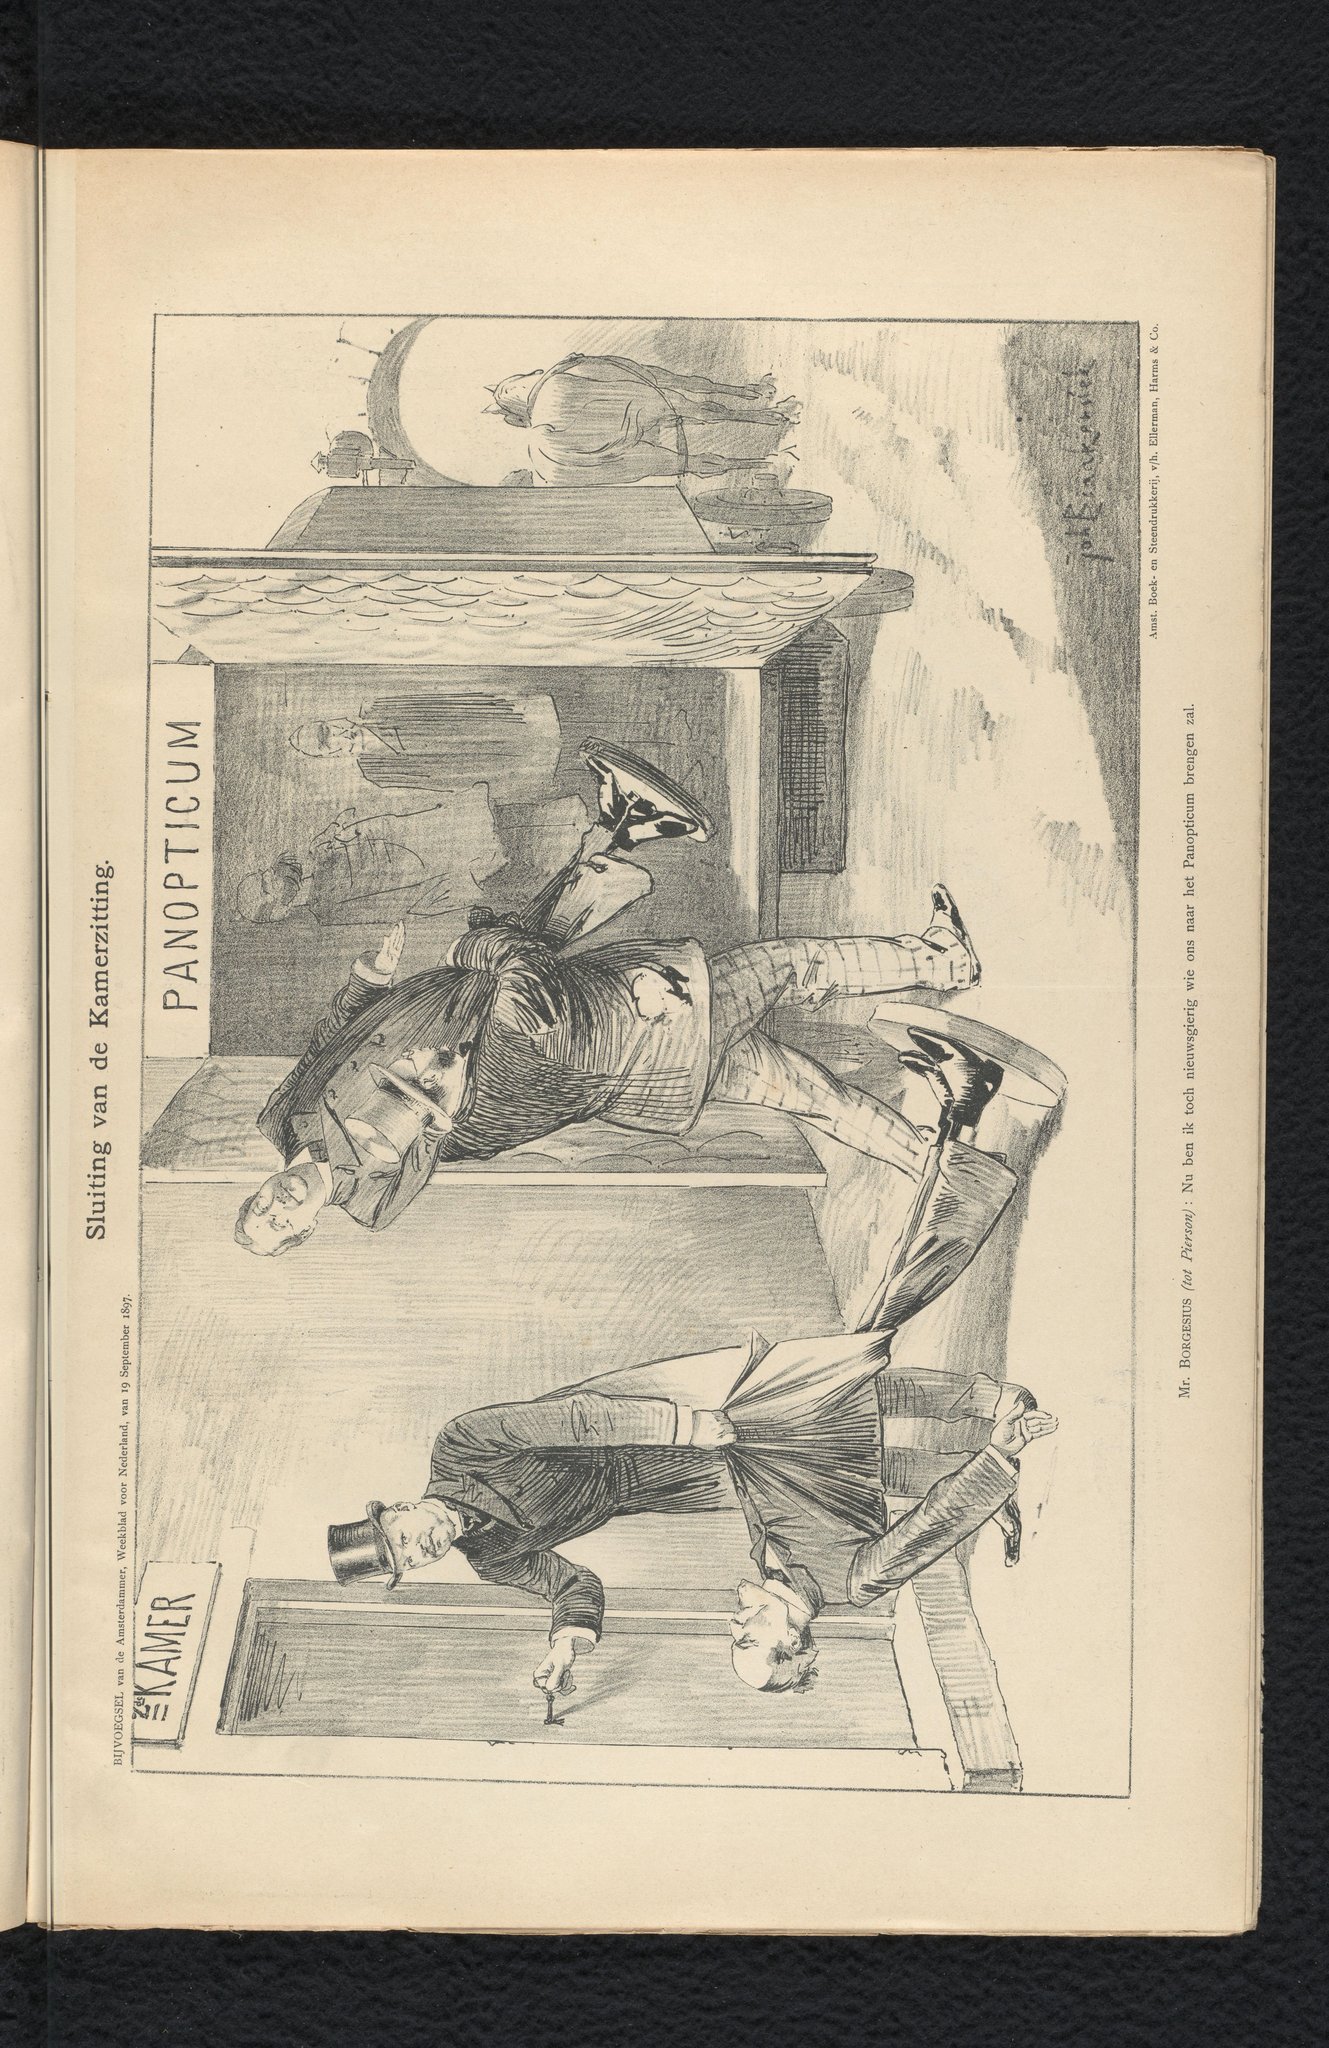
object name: cartoon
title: Sluiting van de Kamerzitting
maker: johan braakensiek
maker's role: draughtsman, print maker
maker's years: 1858-1940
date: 1897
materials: paper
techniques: lithograph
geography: amsterdam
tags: amsterdam, politician, nicolaas gerard pierson, the hague, wax-figure cabinet, political caricatures and satires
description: Bij de sluiting van de oude Tweede Kamer worden politici als wassen beelden door Goeman Borgesius en Pierson afgevoerd naar het panopticum (wassenbeeldenmuseum).